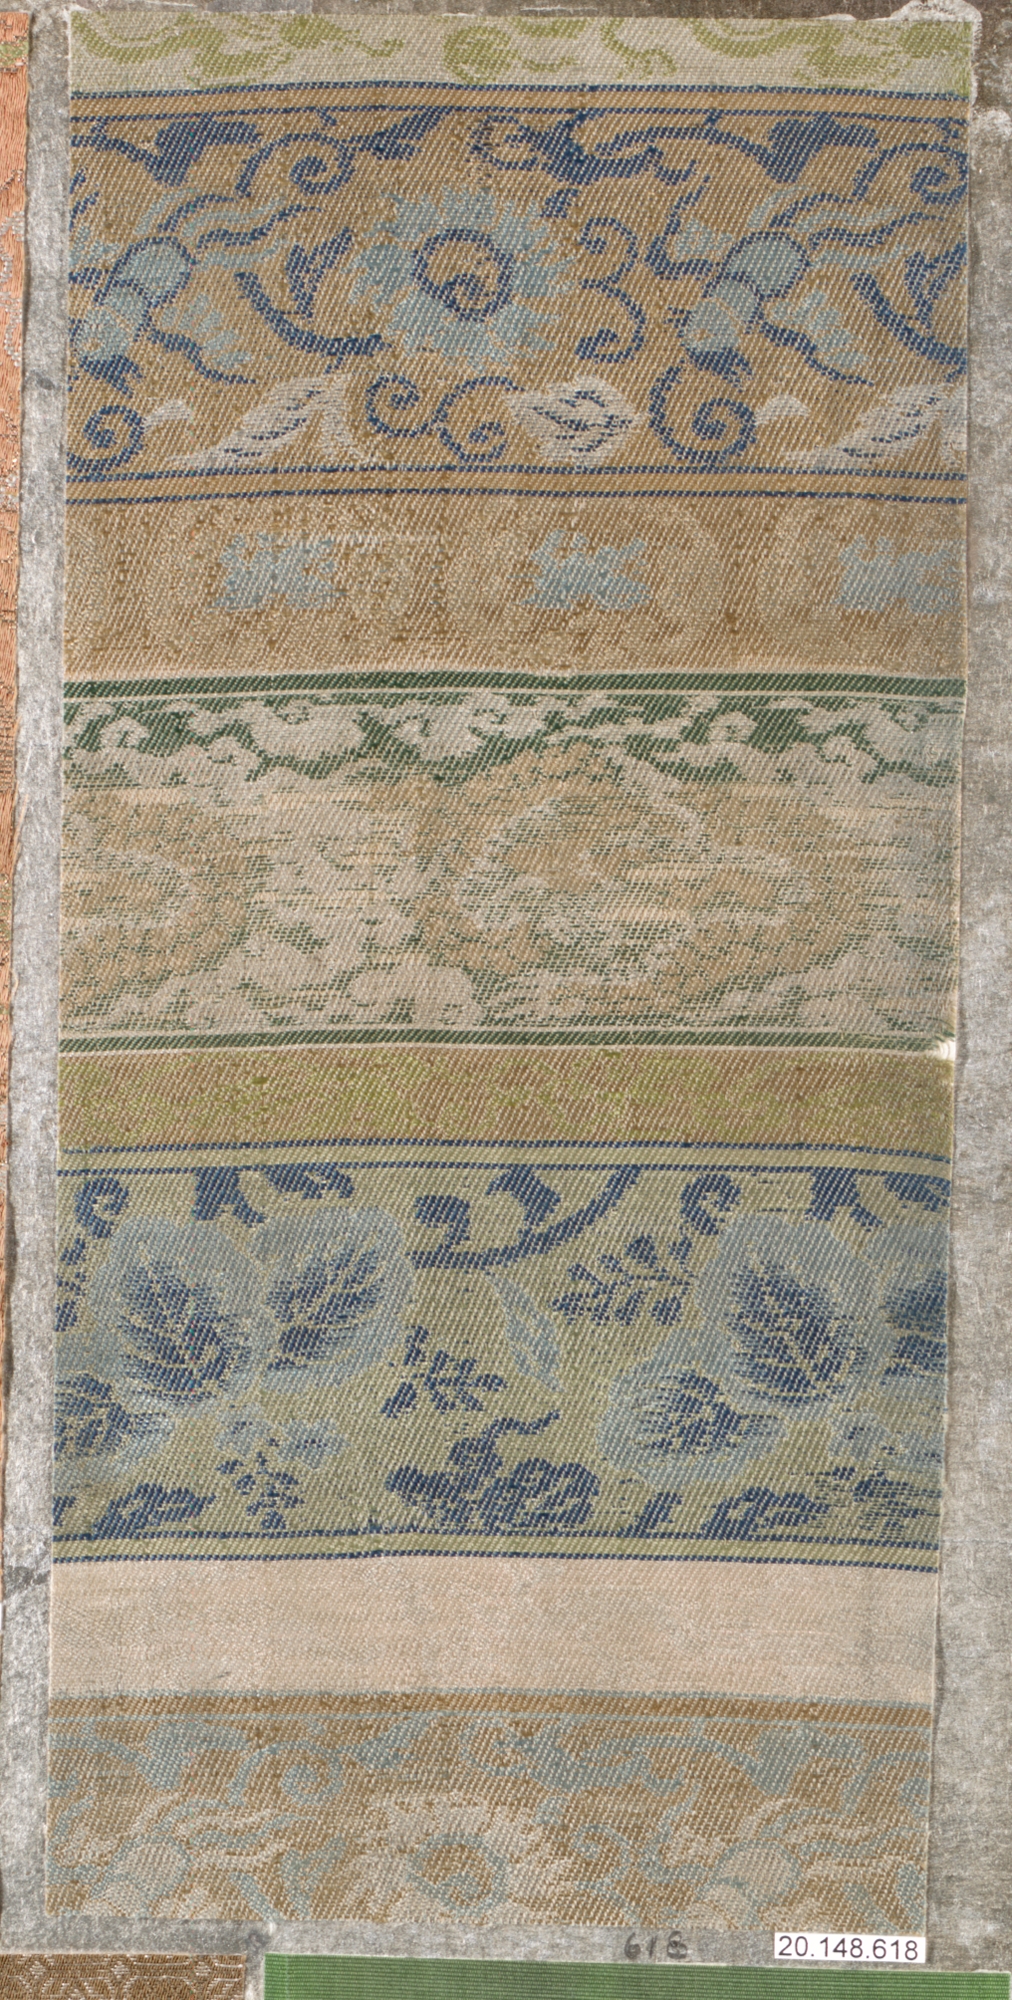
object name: piece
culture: china or japan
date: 1701-1800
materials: silk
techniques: compound weave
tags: flowers,leaves